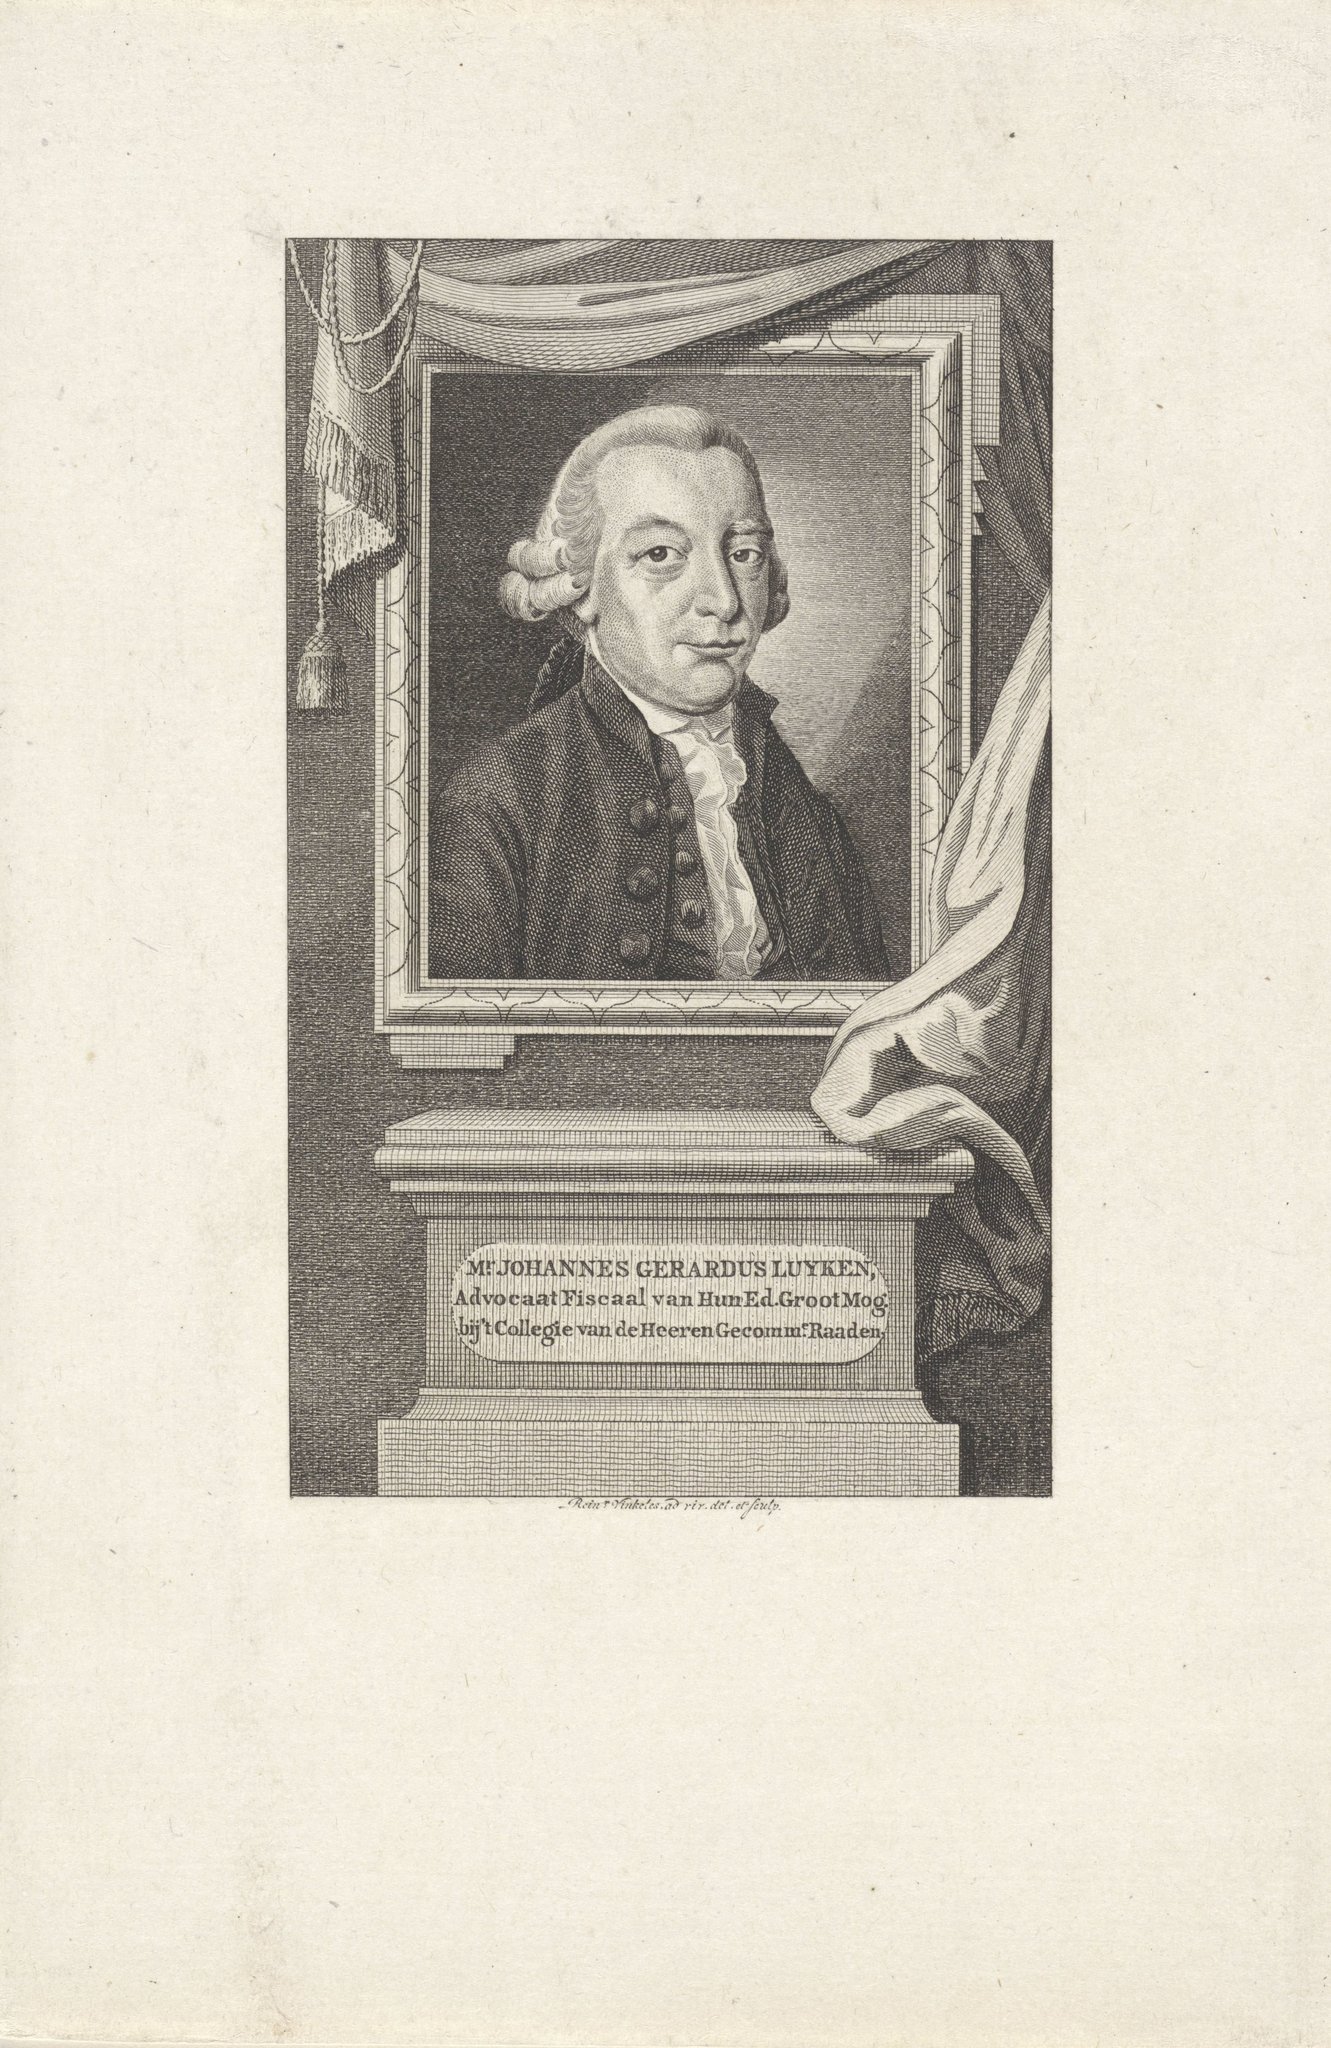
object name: print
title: Portret van de staatsman Johannes Gerardus Luyken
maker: reinier vinkeles (i)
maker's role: draughtsman, print maker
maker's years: 1741-1816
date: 1786-1809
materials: paper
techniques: etching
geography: amsterdam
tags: staatsman, representant, johannes gerardus luyken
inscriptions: collector's mark: Lugt 2228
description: Prent ook gebruikt als boekillustratie in: Wagenaar, Jan. Vaderlandsche historie, (...) ten vervolge van Wagenaars Vaderlandsche historie. Dl. 1-43. Amsterdam: Johannes Allart, 1786-1809.